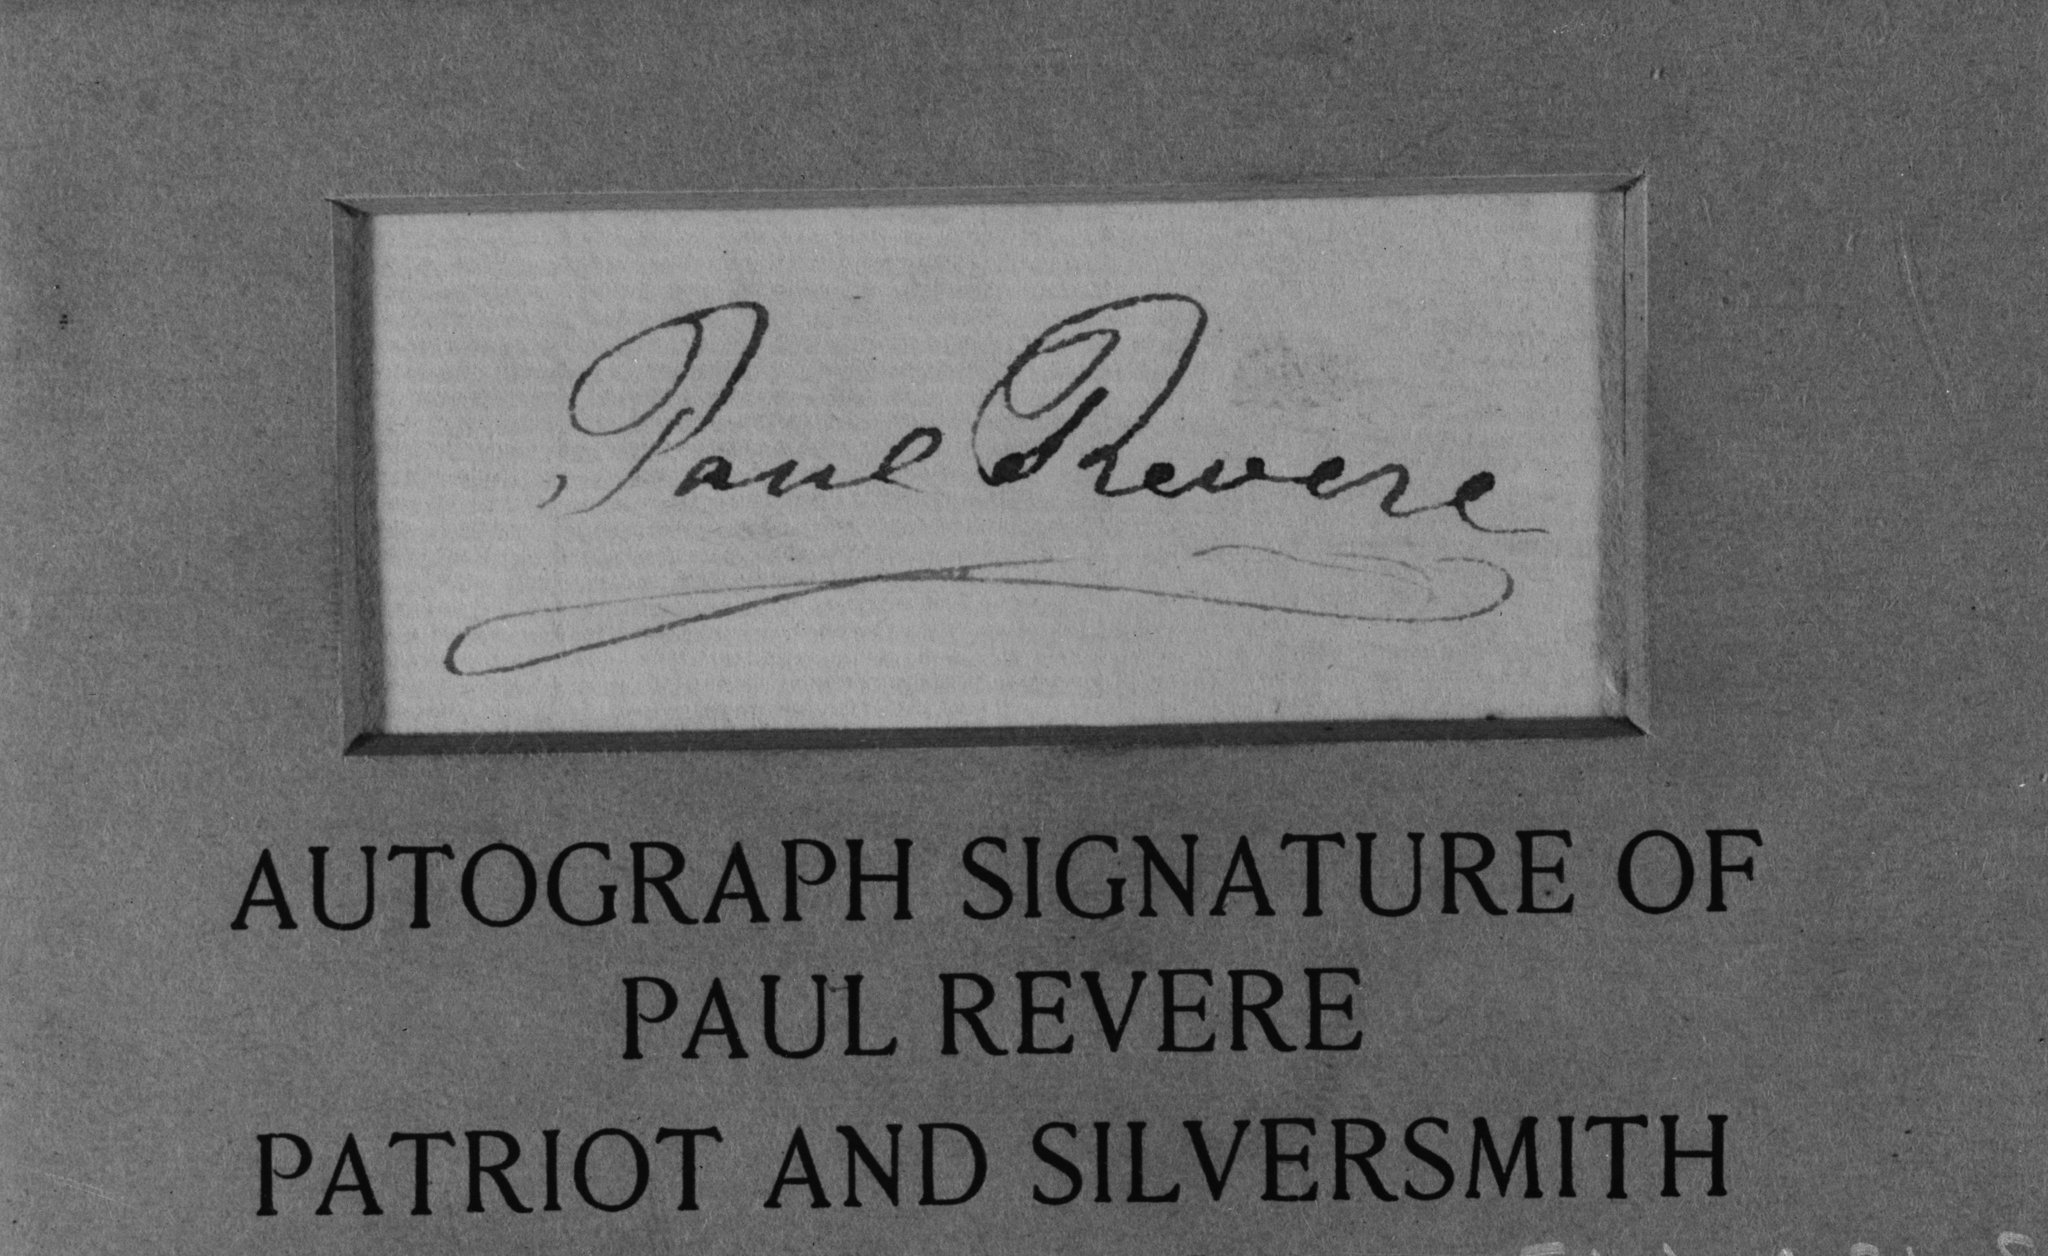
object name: paul revere's autograph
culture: american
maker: paul revere jr.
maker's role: artist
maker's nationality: american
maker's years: 1734-1818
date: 1745-1818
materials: ink, paper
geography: united states